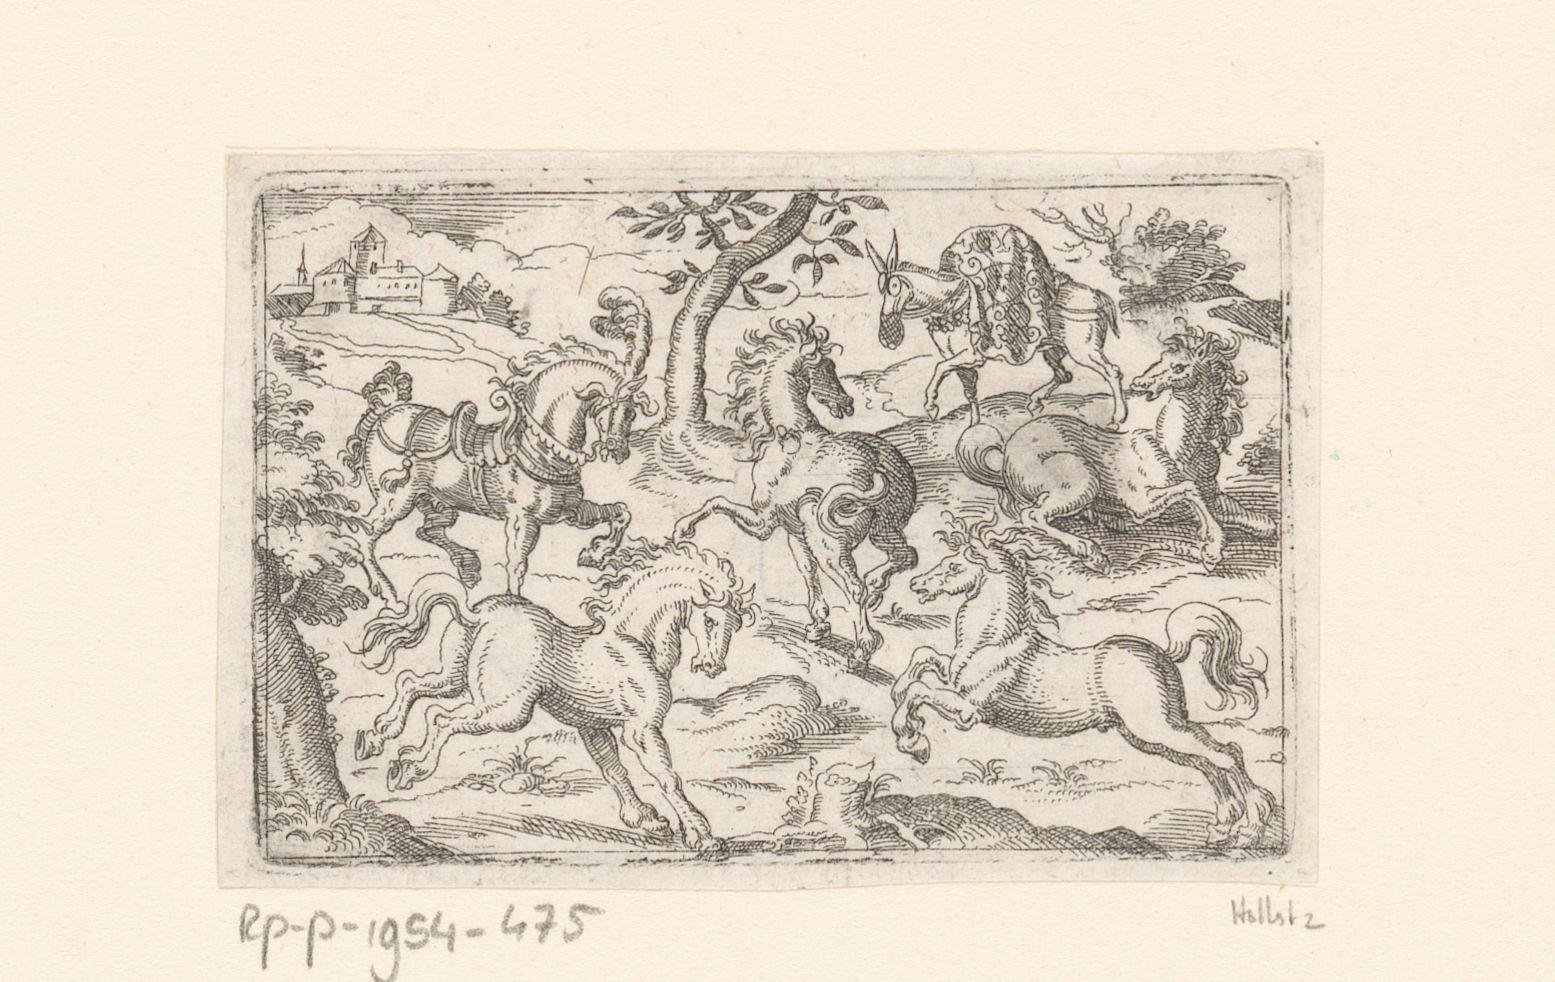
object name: print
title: Dieren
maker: stephan herman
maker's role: print maker, publisher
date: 1578-1596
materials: paper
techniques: etching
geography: ansbach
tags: horse, mule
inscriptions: collector's mark: Lugt 2542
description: Onderdeel van een serie van tien prenten van dieren.